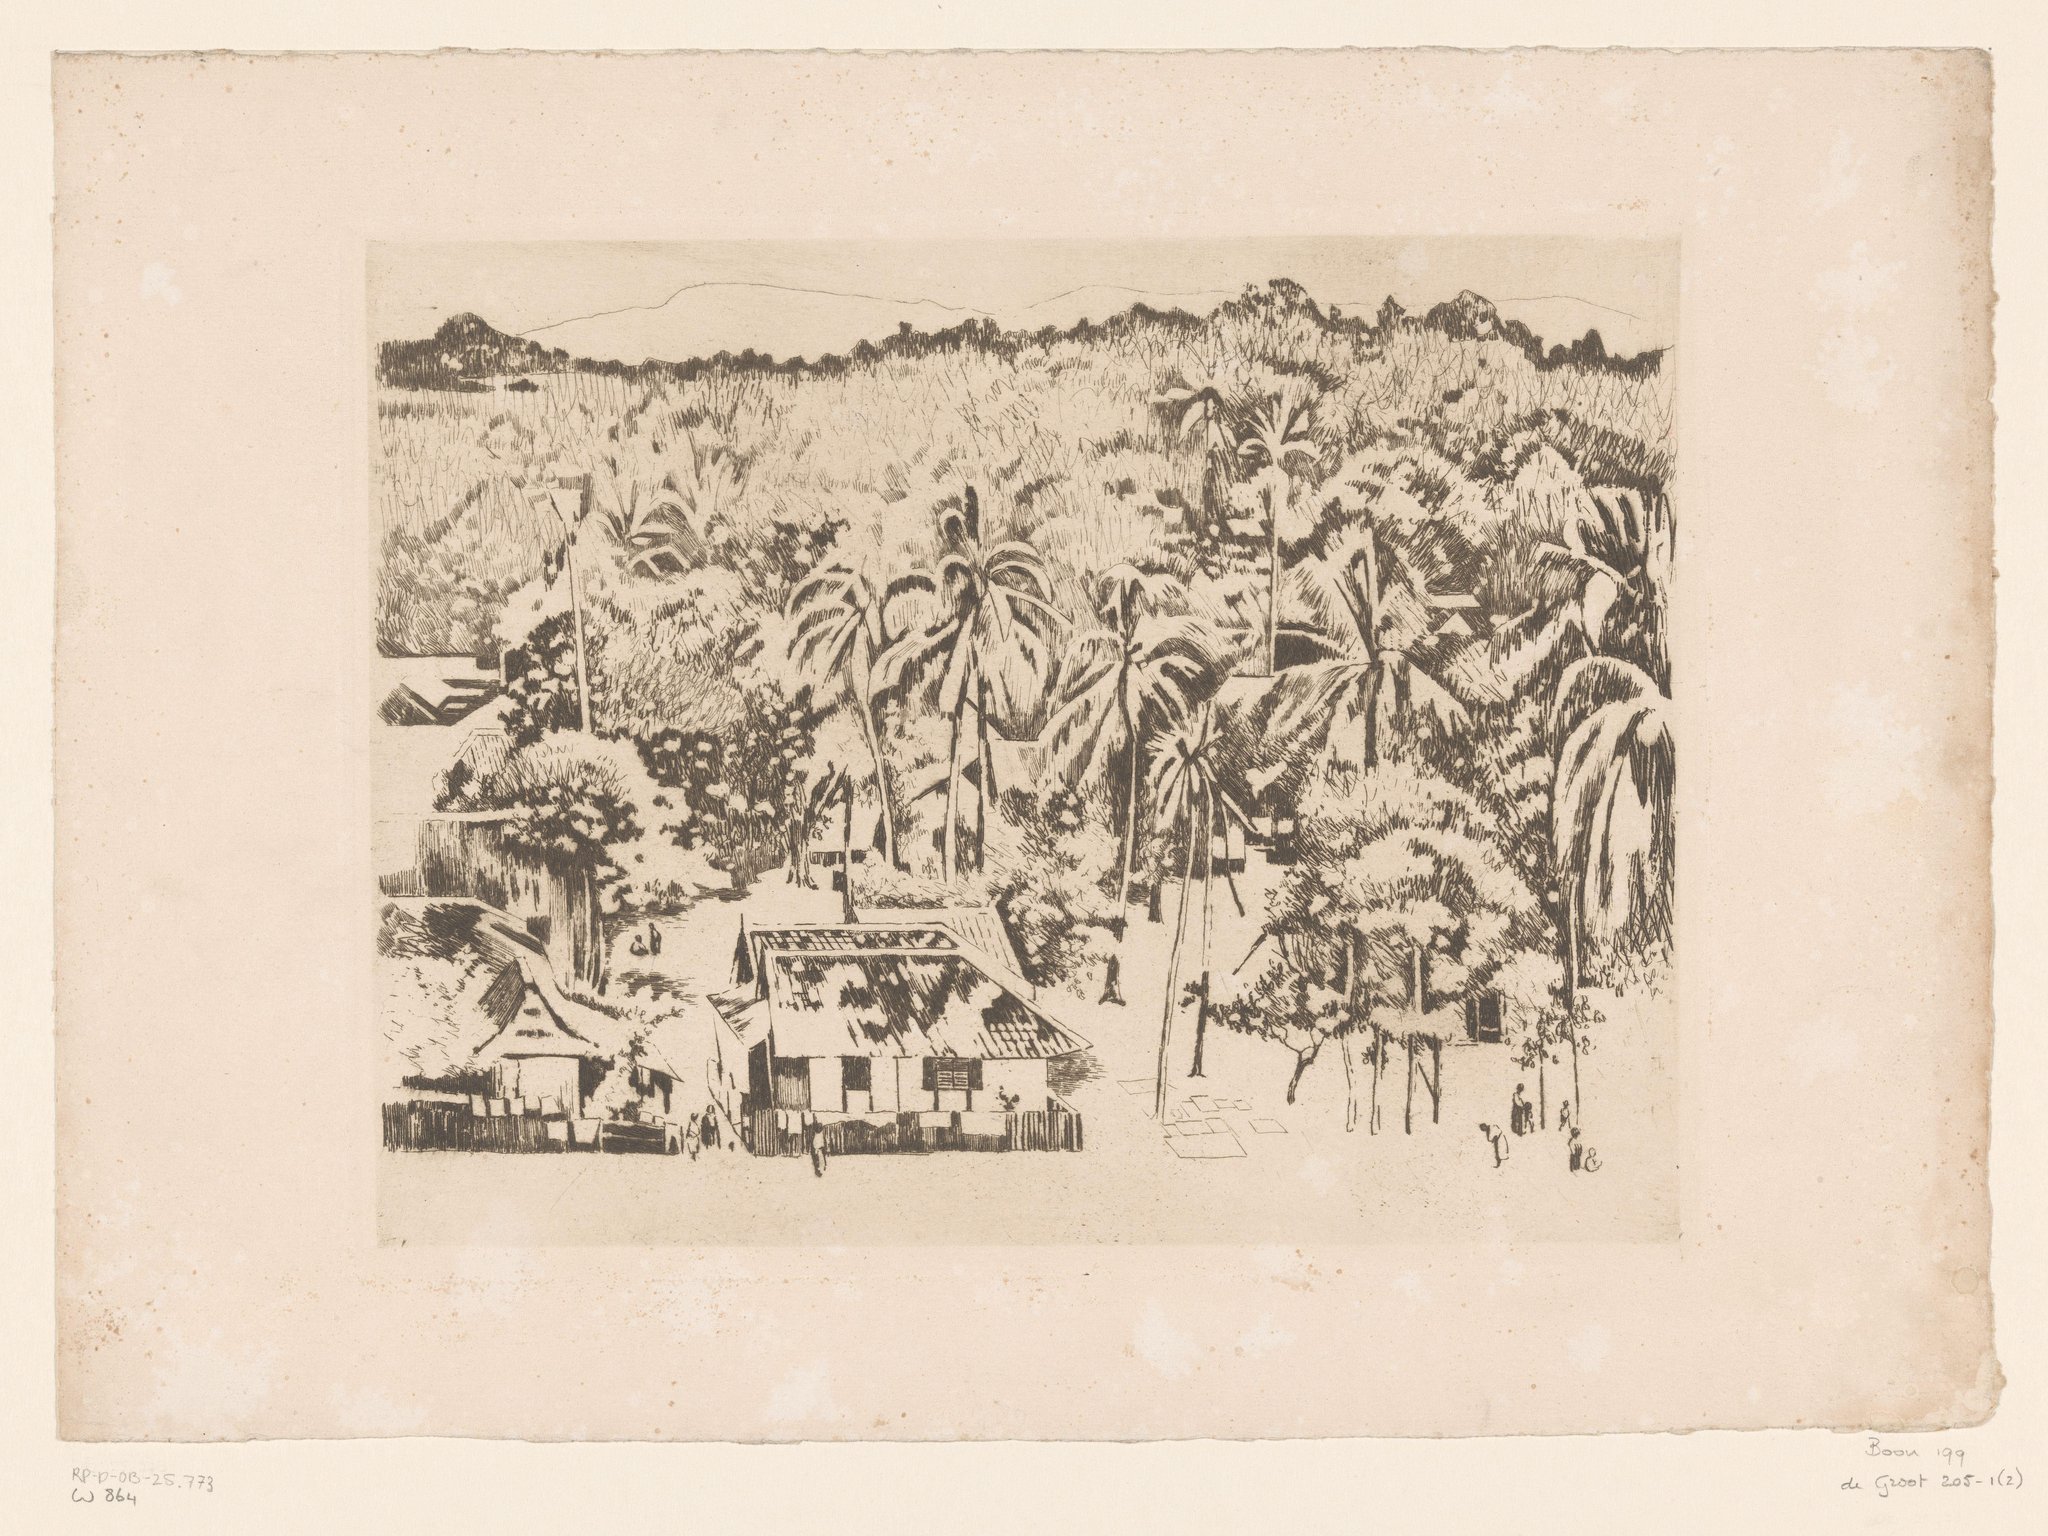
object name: print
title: Gezicht op huizen en begroeiing in Buitenzorg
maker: willem witsen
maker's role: draughtsman, painter, print maker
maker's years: 1860-1923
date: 1921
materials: paper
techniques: etching, intaglio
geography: amsterdam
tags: plantation, rural housing, e.g. country-house, villa, cottage, mountains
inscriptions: watermark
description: Gezien vanuit Hotel Bellevue in Buitenzorg.